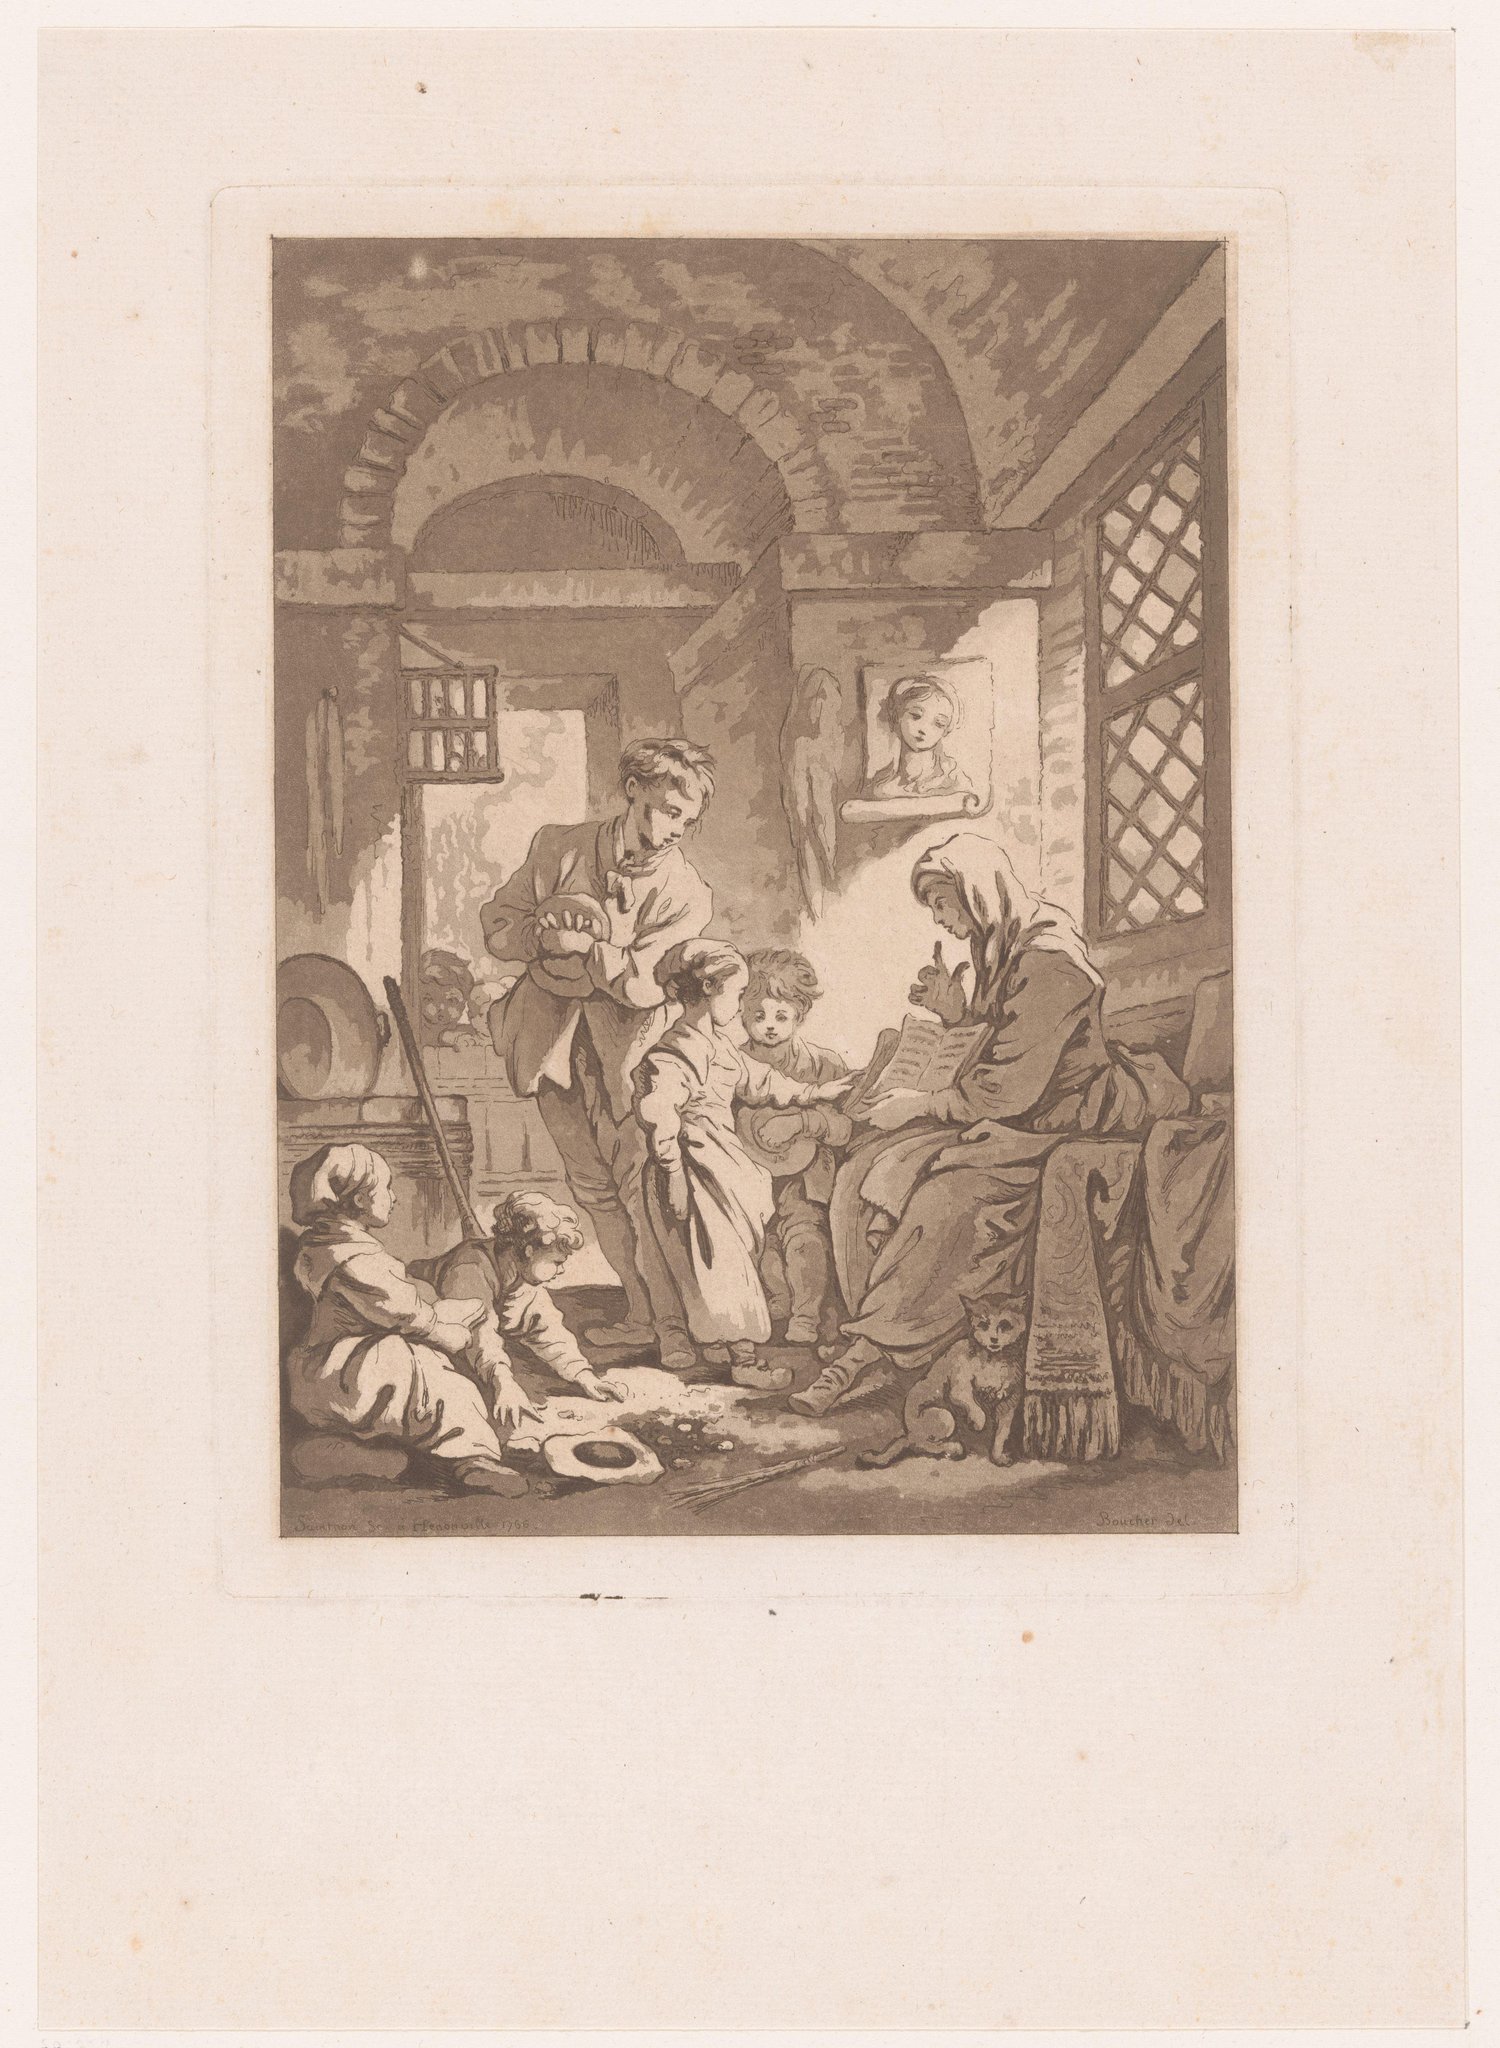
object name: print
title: Leesles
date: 1766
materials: paper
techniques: aquatint, etching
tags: reading, education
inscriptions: collector's mark: Lugt 2228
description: Vrouw leert vier kinderen lezen in een interieur. Aan haar benen zit een kat. Tegenover haar staat een jongeman. Door het raam op de achtergrond kijken twee kinderen naar binnen.